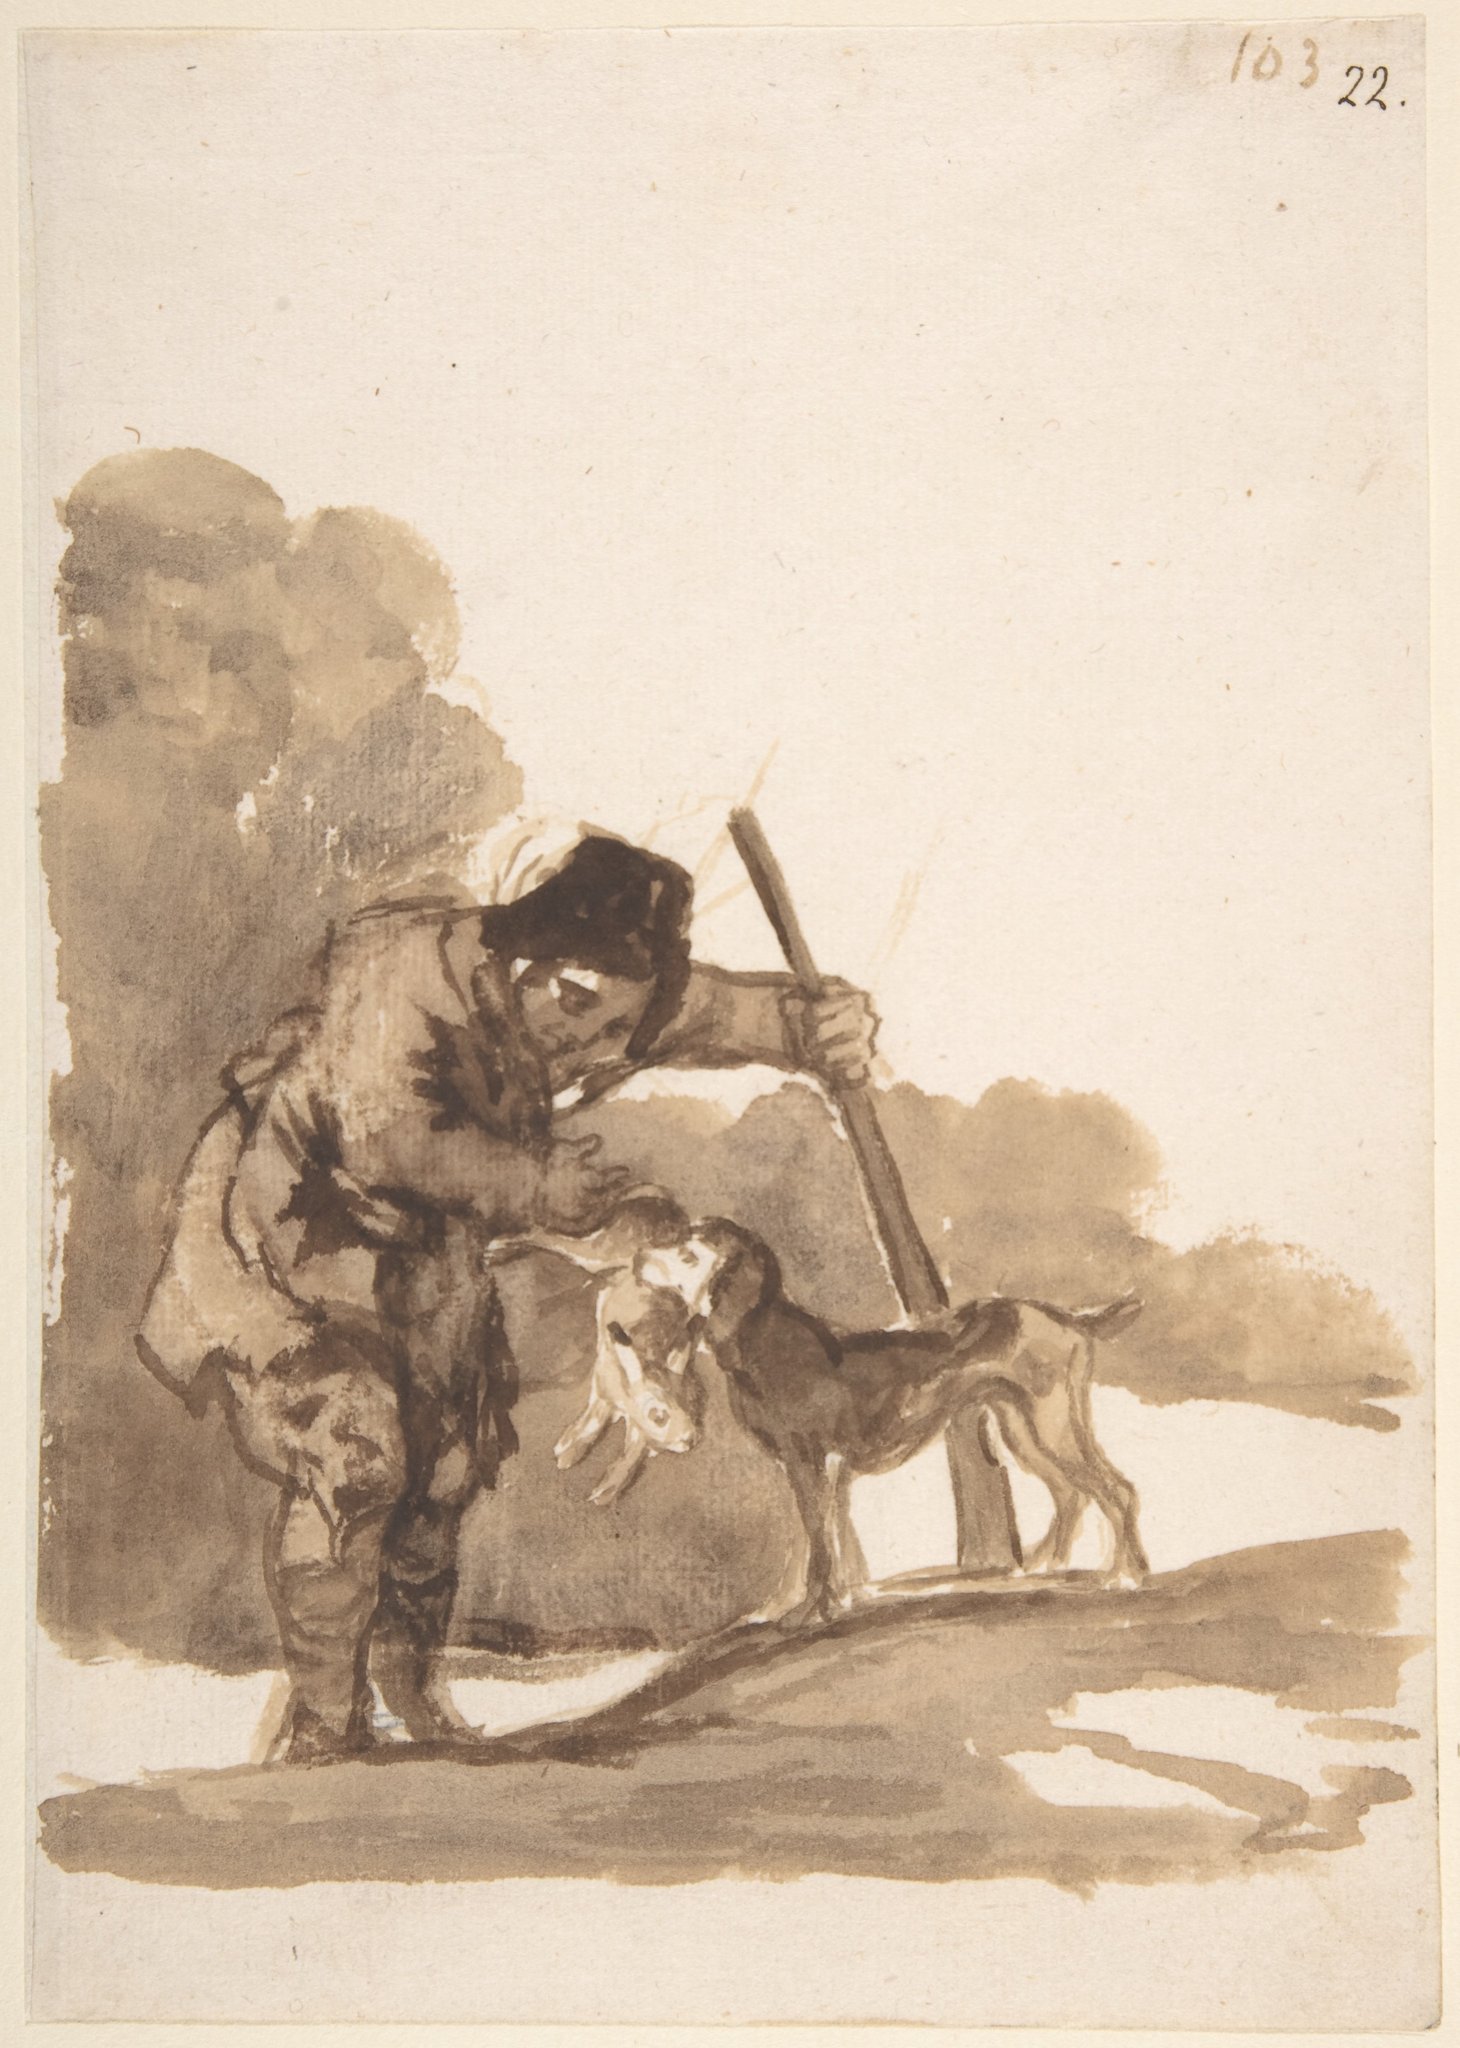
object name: drawing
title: Rabbit hunter with a Retriever; folio 103 from the "Images of Spain" Album (F)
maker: goya (francisco de goya y lucientes)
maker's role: artist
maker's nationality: spanish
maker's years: 1746-1828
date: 1812-1820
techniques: brush, wash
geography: spain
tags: firearms,men,hunting,dogs,rabbits